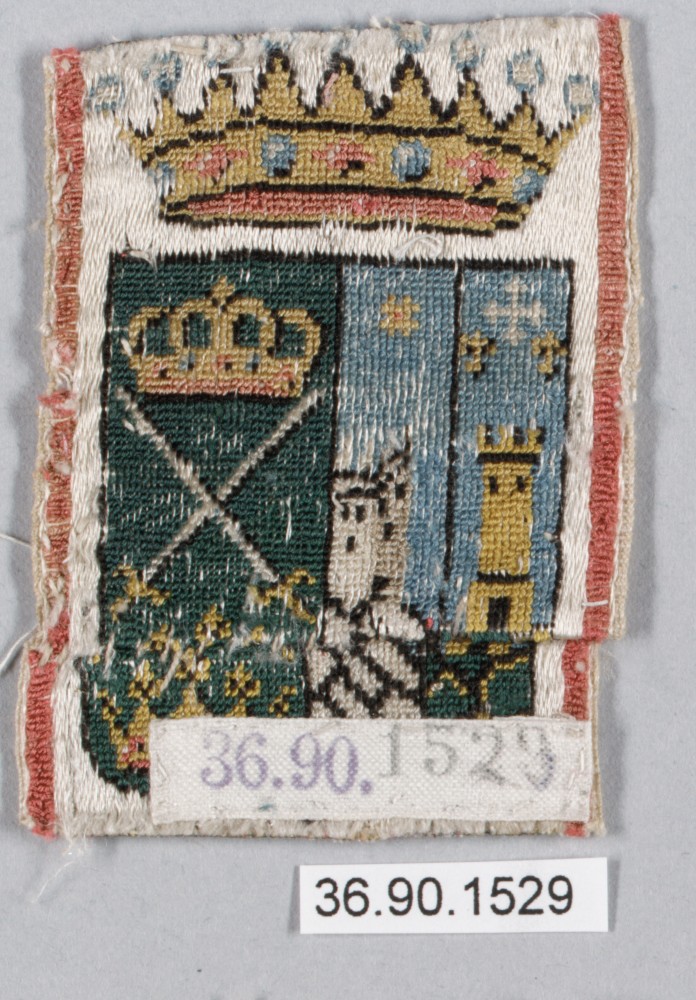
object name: galloon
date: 1701-1900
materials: silk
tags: coat of arms